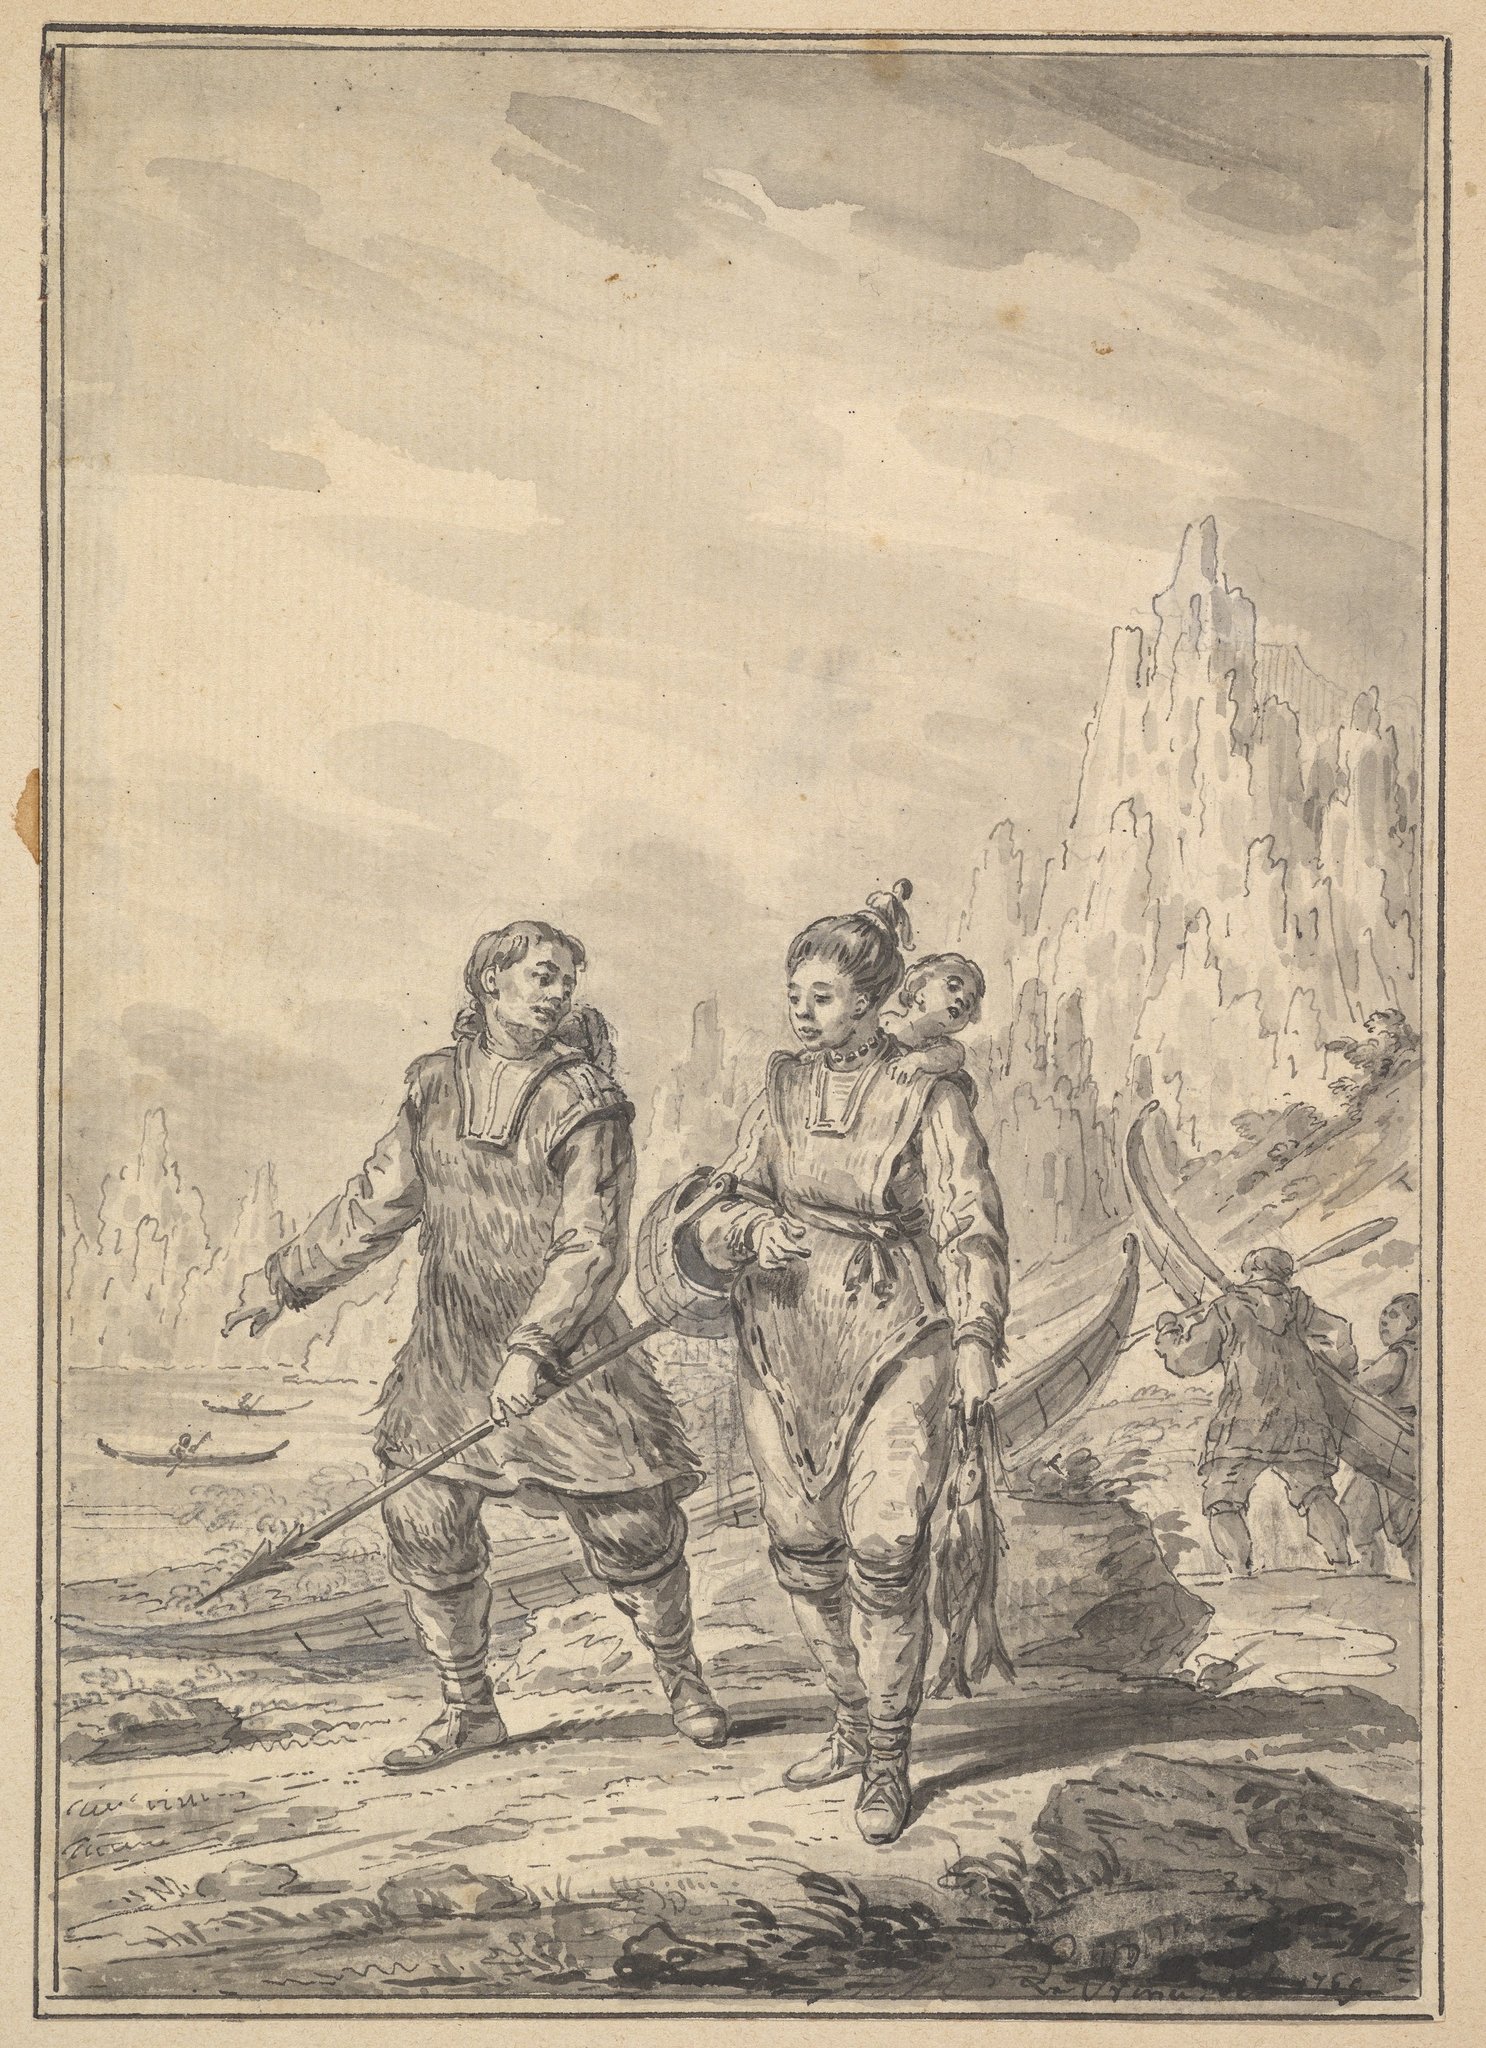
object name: drawing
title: Inuit Manner of Dress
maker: jean-baptiste le prince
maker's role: artist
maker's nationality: french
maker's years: 1734-1781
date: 1769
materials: chalk, graphite, ink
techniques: brush, pen, wash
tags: children,men,women,fish,family